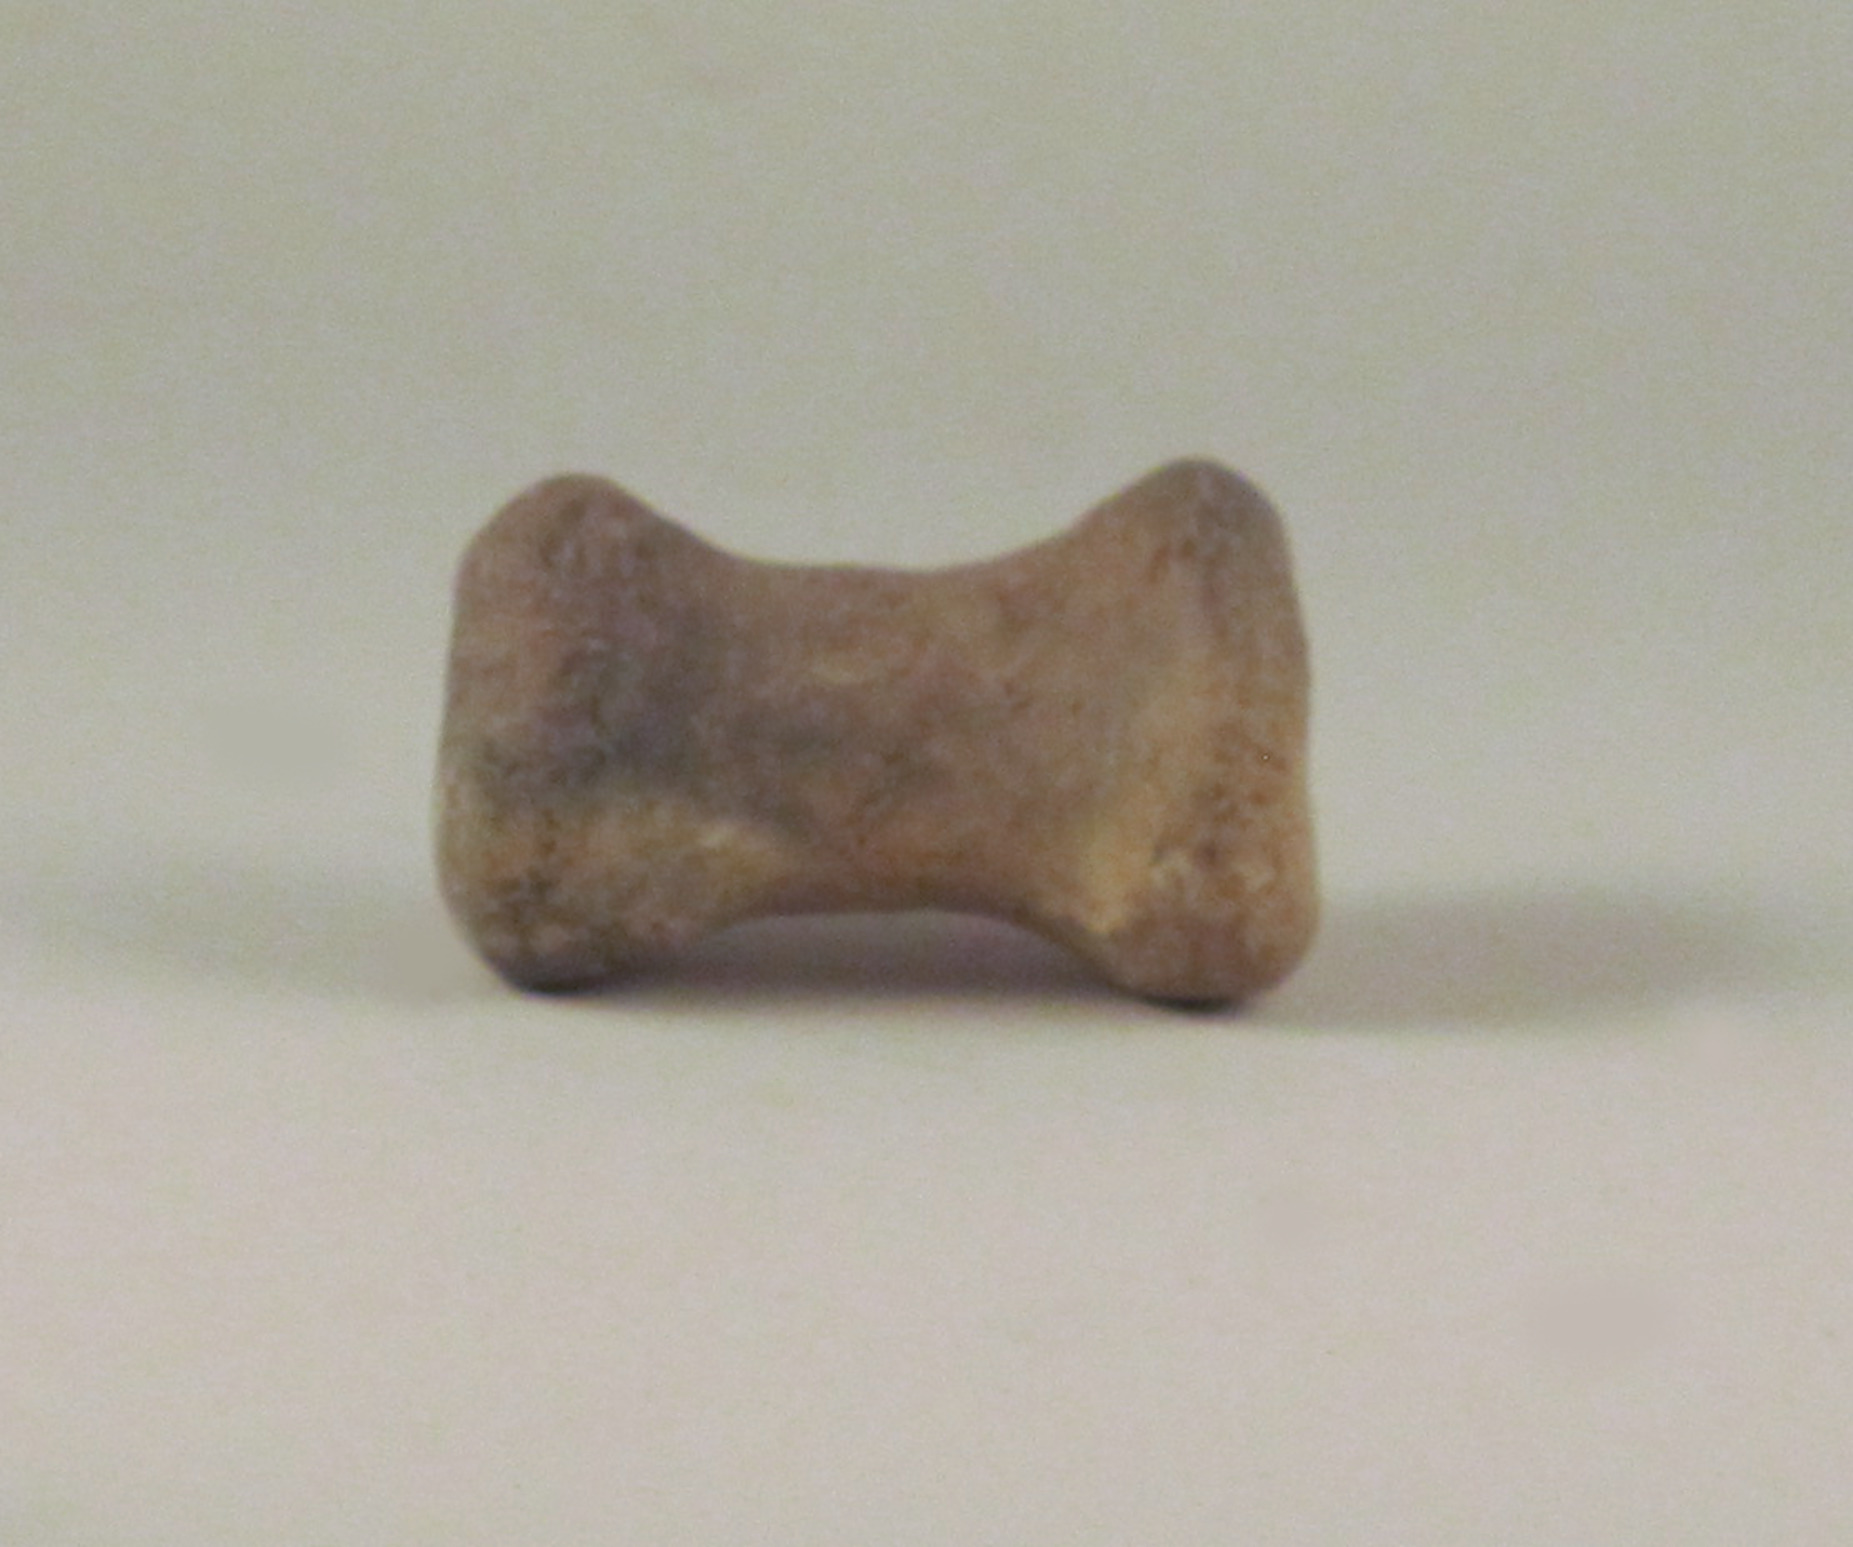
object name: spindle whorl, reel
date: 7000 BCE-330 CE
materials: clay